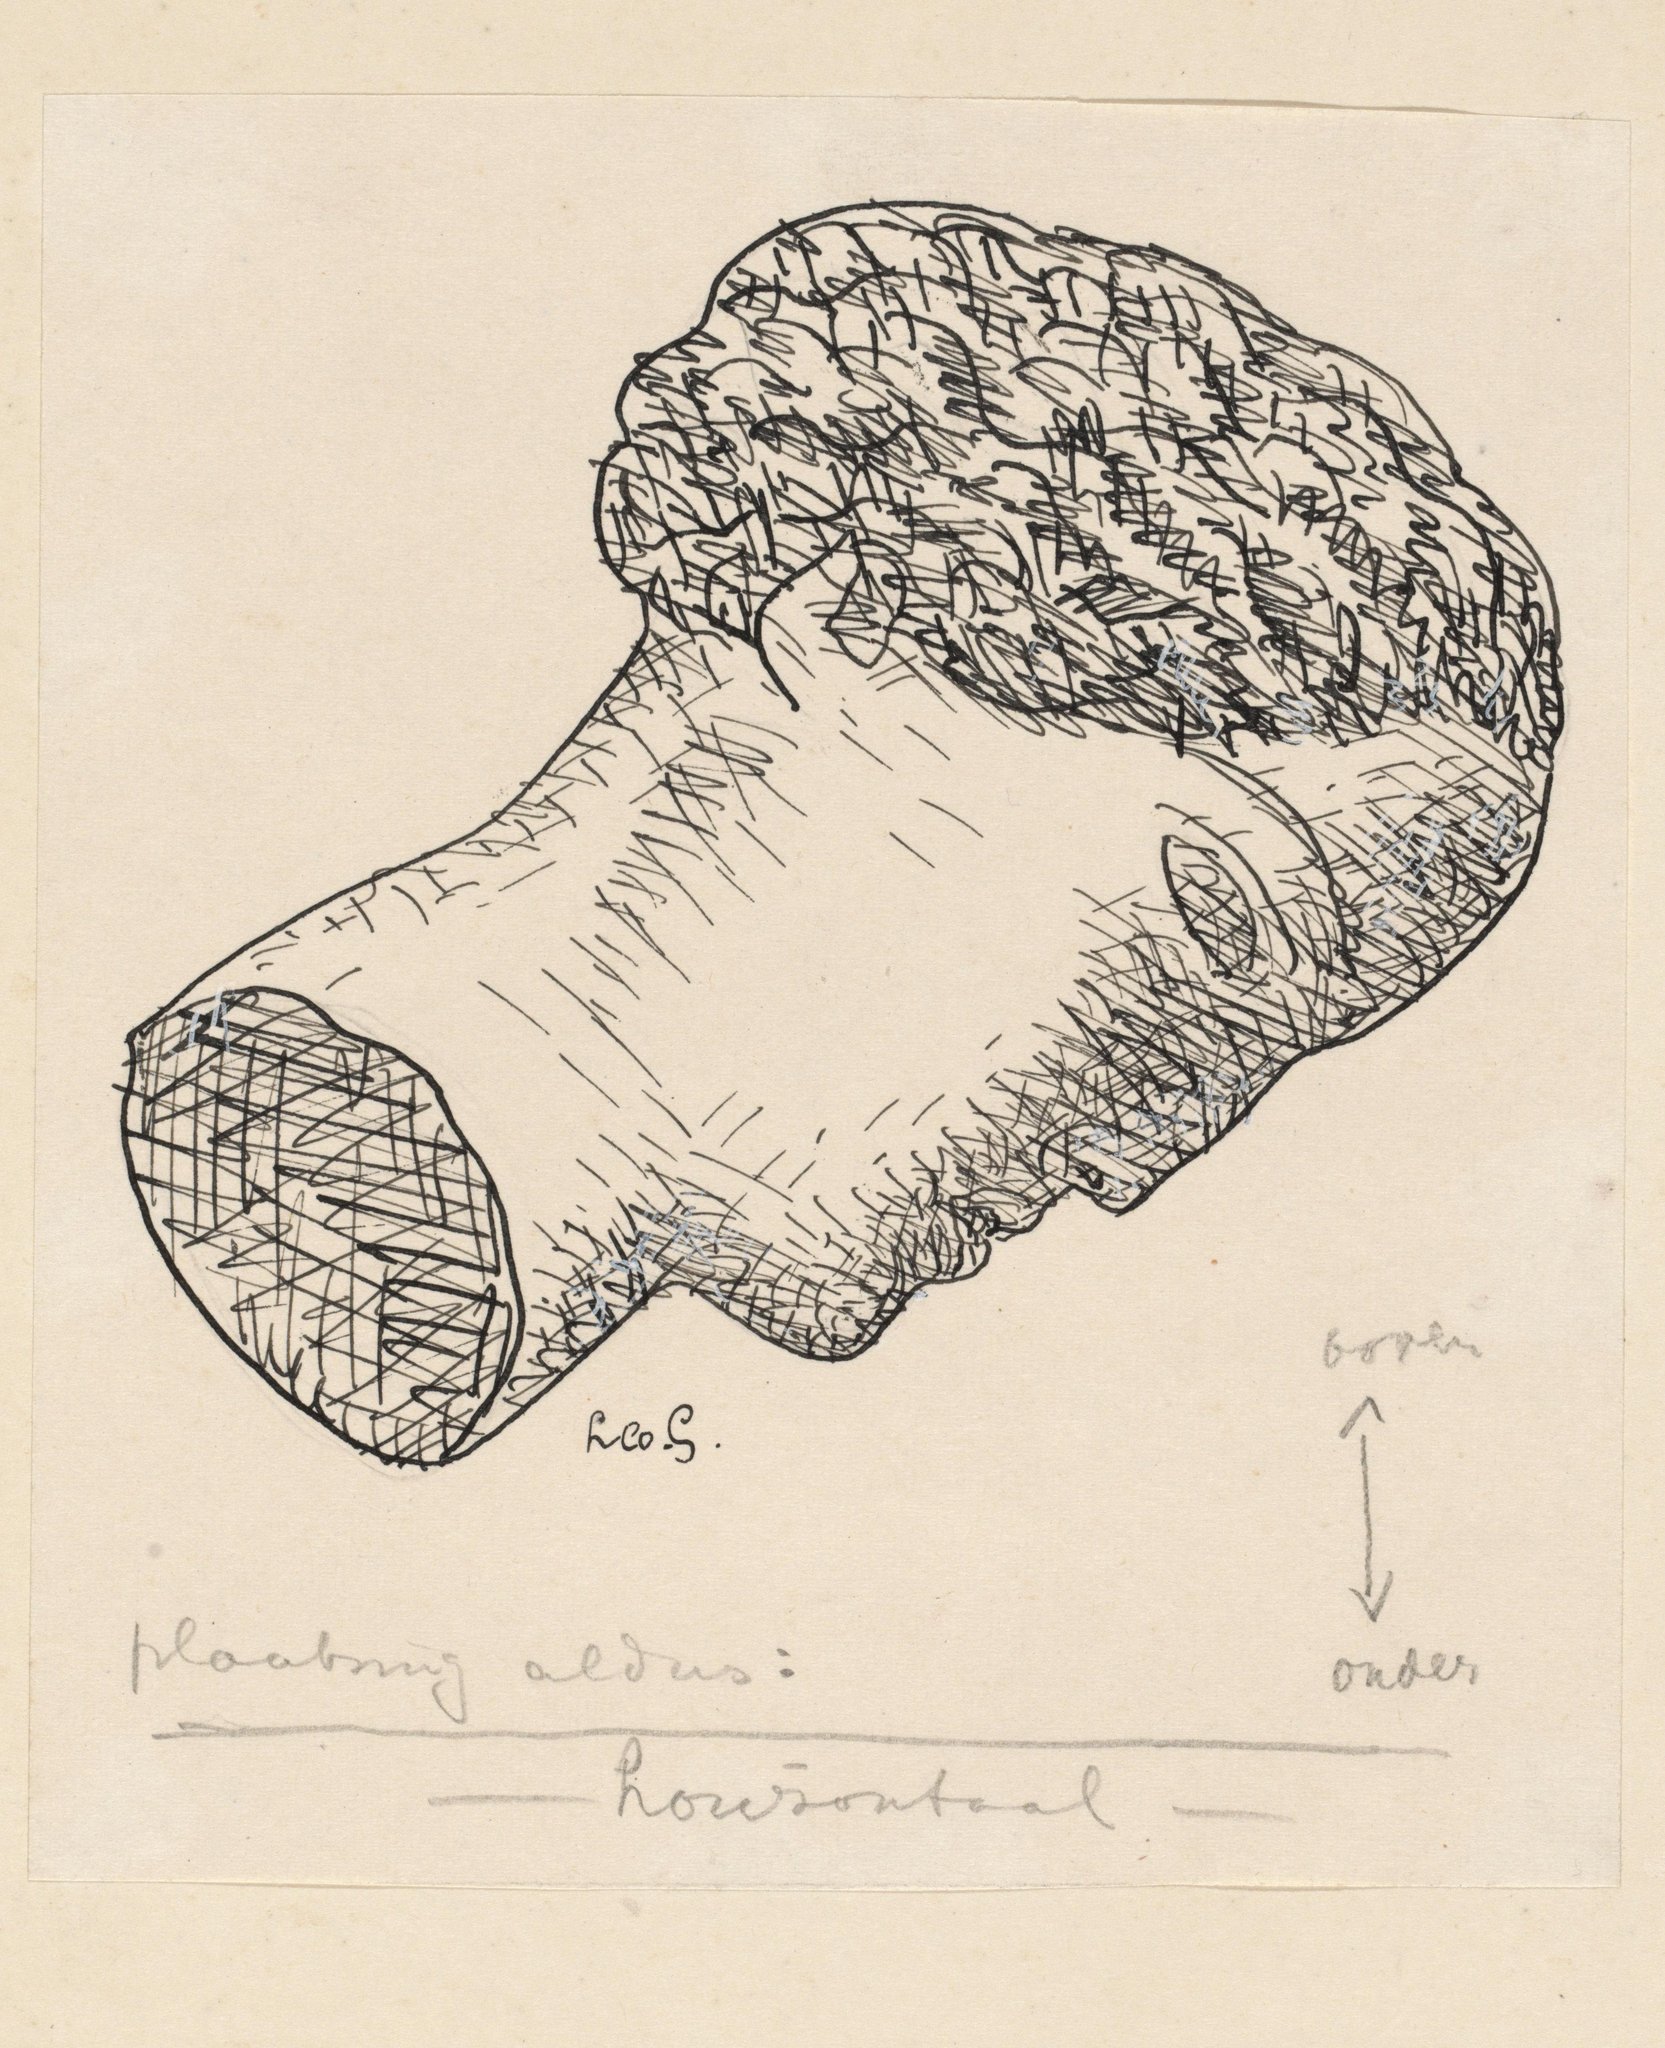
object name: design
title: Vrouwenhoofd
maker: leo gestel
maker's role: draughtsman, print maker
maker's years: 1881-1941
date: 1891-1941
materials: paint, ink, paper, pencil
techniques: pen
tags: head (human) - aa - female human figure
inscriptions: collector's mark: Lugt 2228